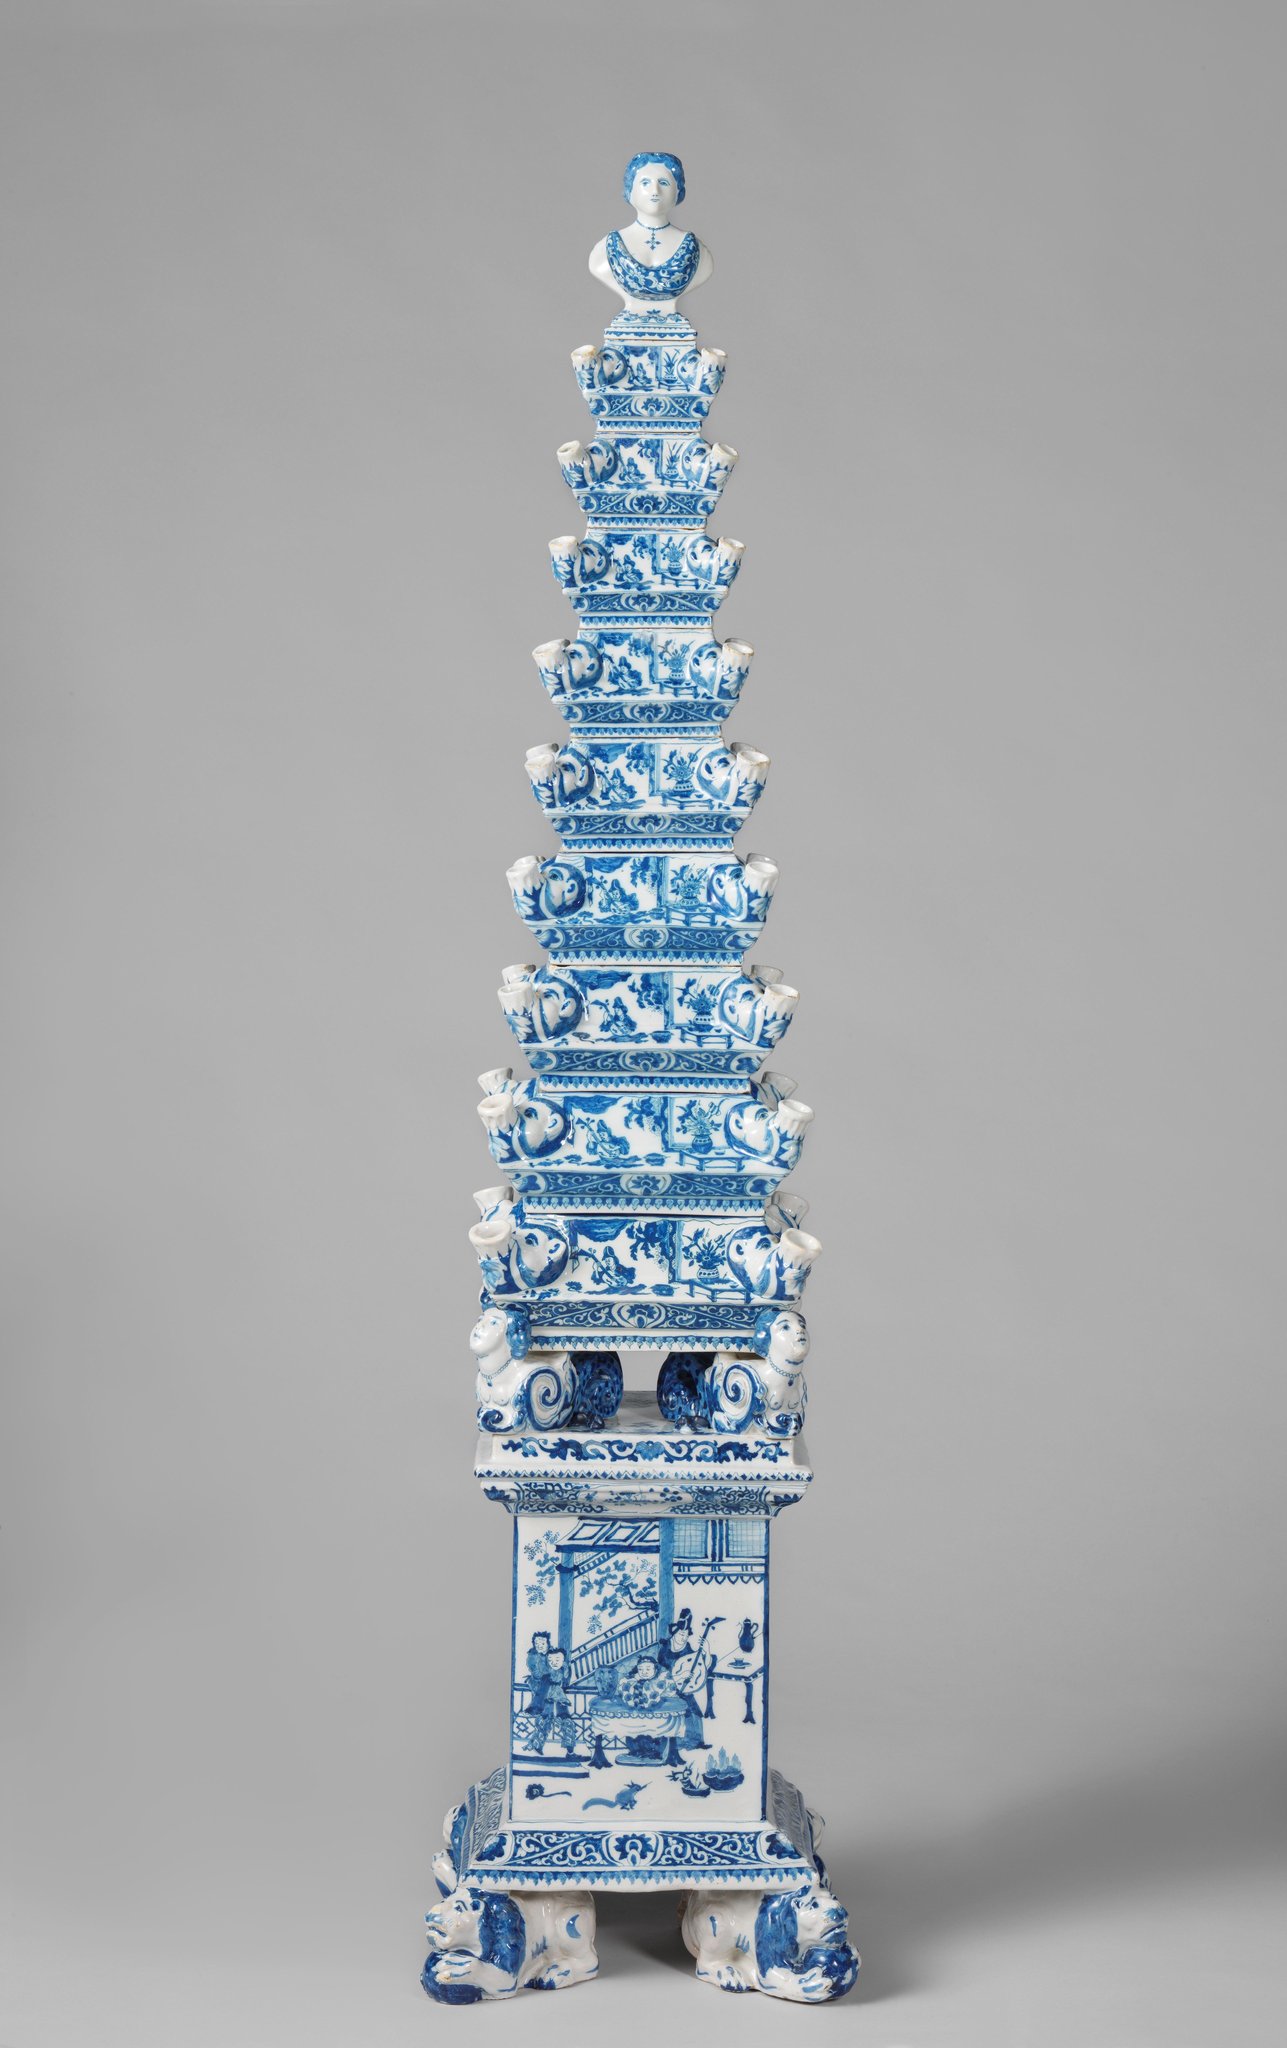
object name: bloempiramide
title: Flower pyramid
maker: lambertus van eenhoorn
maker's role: plateelbakker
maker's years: 1651-1721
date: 1692-1700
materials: earthenware, glaze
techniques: painted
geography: delft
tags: flowers, one person playing string instrument (plucked), beasts of prey, predatory animals: lion, chest, bust - aa - female human figure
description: Voetstuk van bloempiramide van faience, blauw beschilderd in de glazuur. Musicerende, zittende en spelende figuren in tuin. Sokkel rustend op vier liggende leeuwtjes.